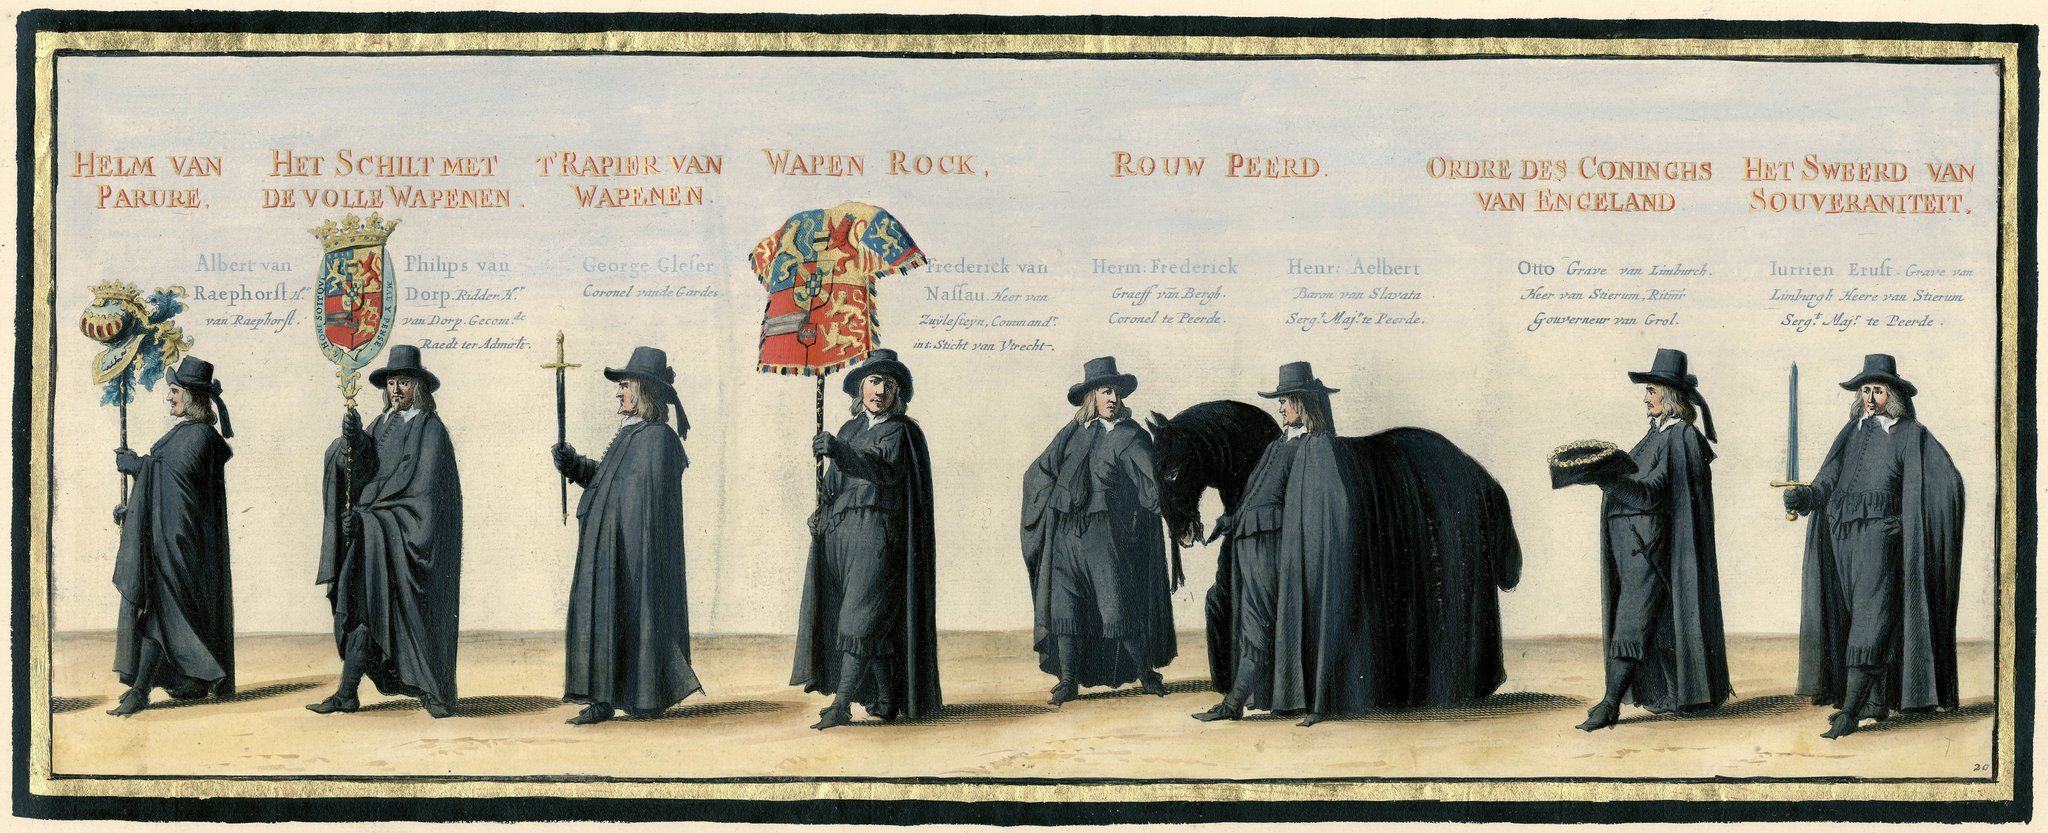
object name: print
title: Begraeffenisse van syne hoogheyt Frederick Henrick. Luxe ingekleurde uitgave van de prenten van de begrafenisstoet van Frederik Hendrik in 1647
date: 1651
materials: paint, paper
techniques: colour, etching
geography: the hague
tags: the hague, frederick henry (prince of orange)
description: De begrafenisstoet van Frederik Hendrik, plaat nr. 20 met de Nassausche Wapenrok. Ingekleurde prent in een omlijsting versierd met goud en ingeplakt in de luxe editie uit ca. 1755 van het boek 'Begraeffenisse van syne hoogheyt Frederick Henrick' van Pieter Post, uitgegeven te Amsterdam in 1651.